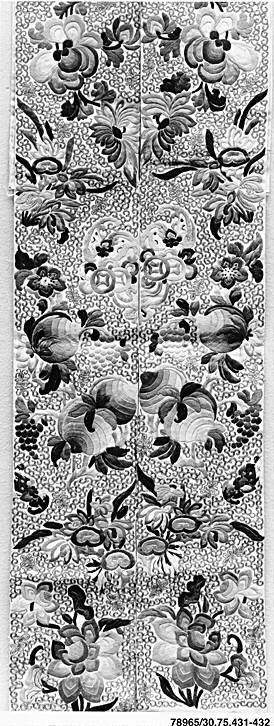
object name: sleeve band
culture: chinese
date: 1801-1900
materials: metal thread, silk